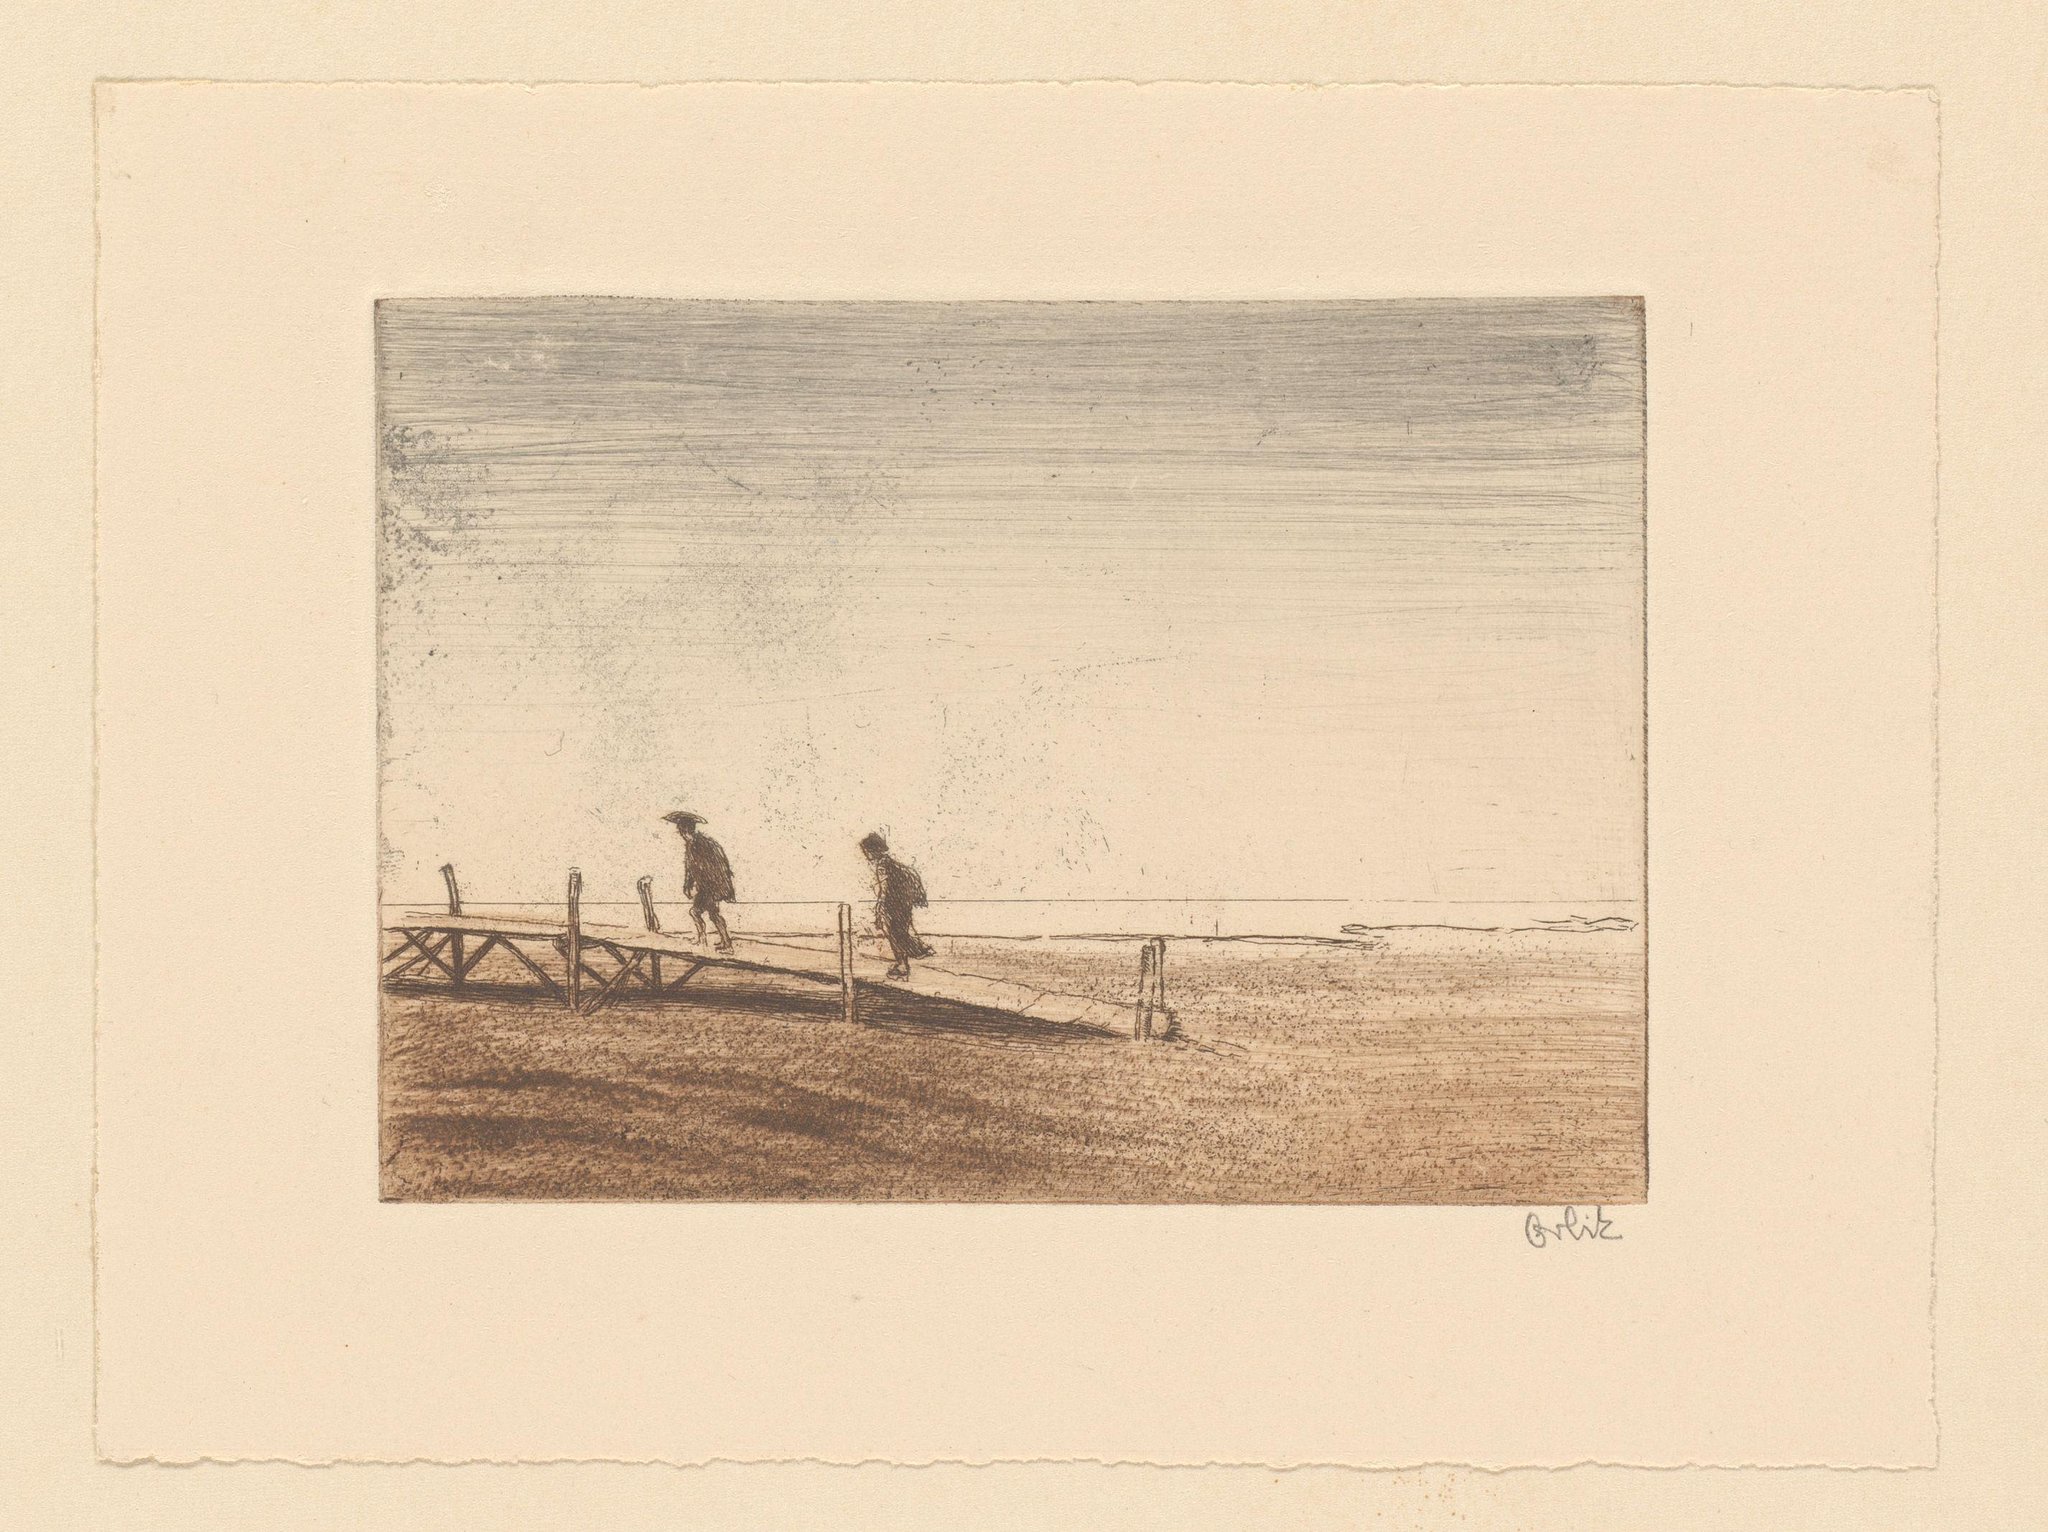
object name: print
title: Uit Japan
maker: emil orlik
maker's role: painter, print maker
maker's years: 1870-1932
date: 1901-1903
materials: paper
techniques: drypoint, etching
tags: landscape with bridge, viaduct or aqueduct, bridge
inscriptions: collector's mark: Lugt 2228